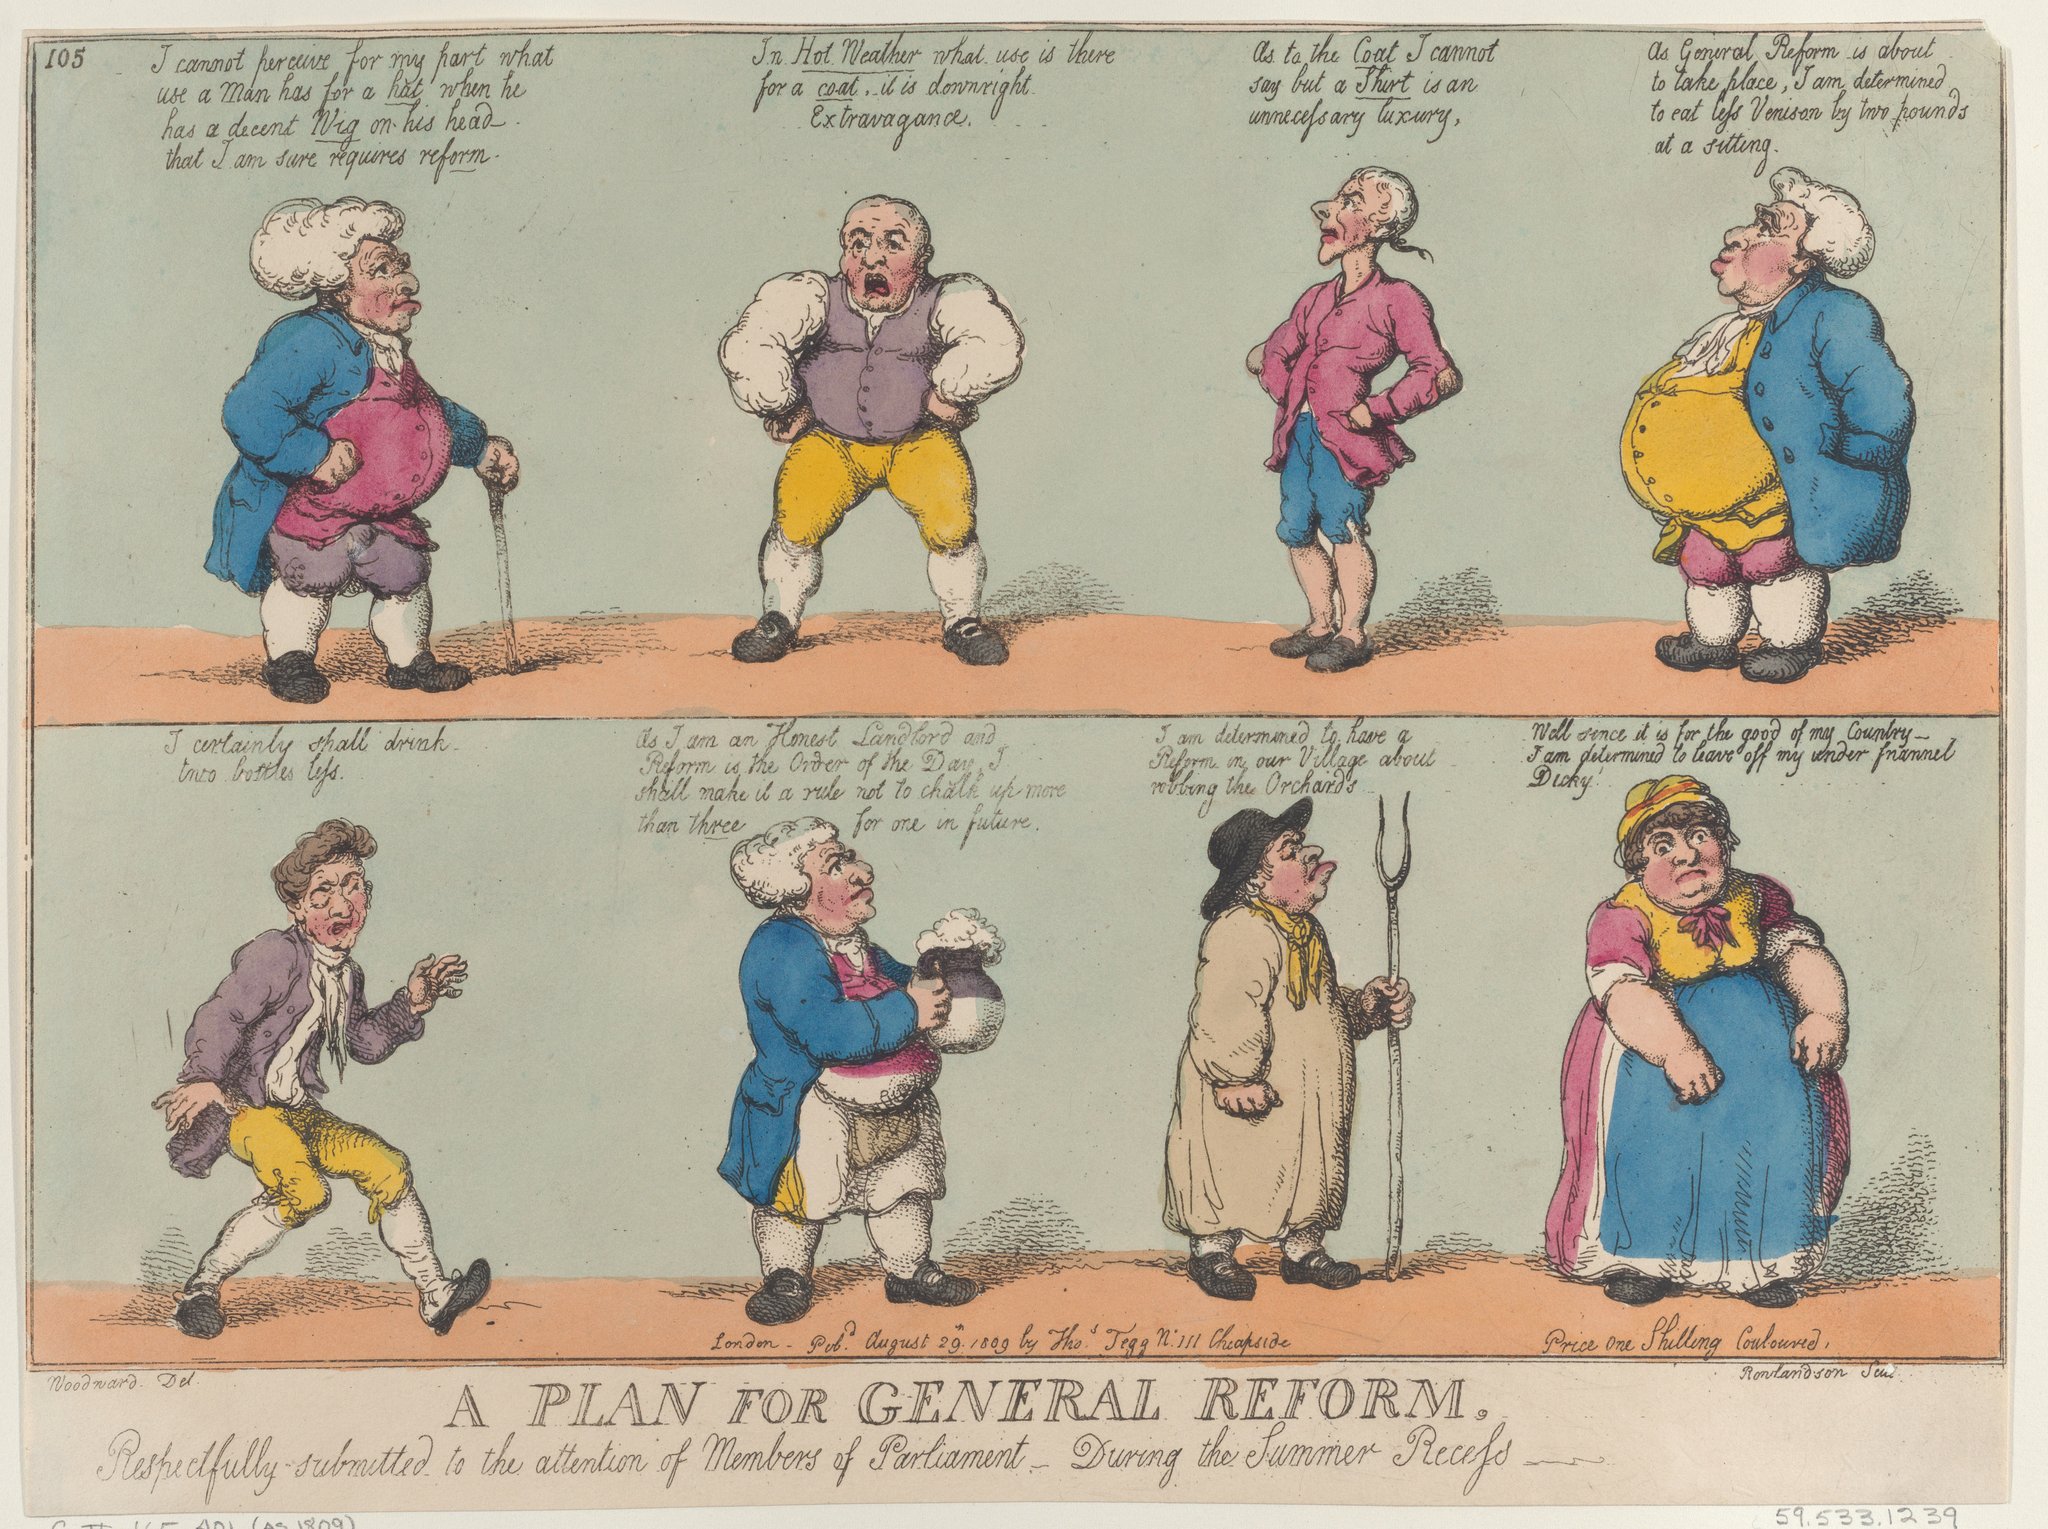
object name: print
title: A Plan for General Reform, Respectfully submitted to the attention of Members of Parliament, During the Summer Reccess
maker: thomas rowlandson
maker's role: artist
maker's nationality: british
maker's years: 1757-1827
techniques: etching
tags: satire,men,women